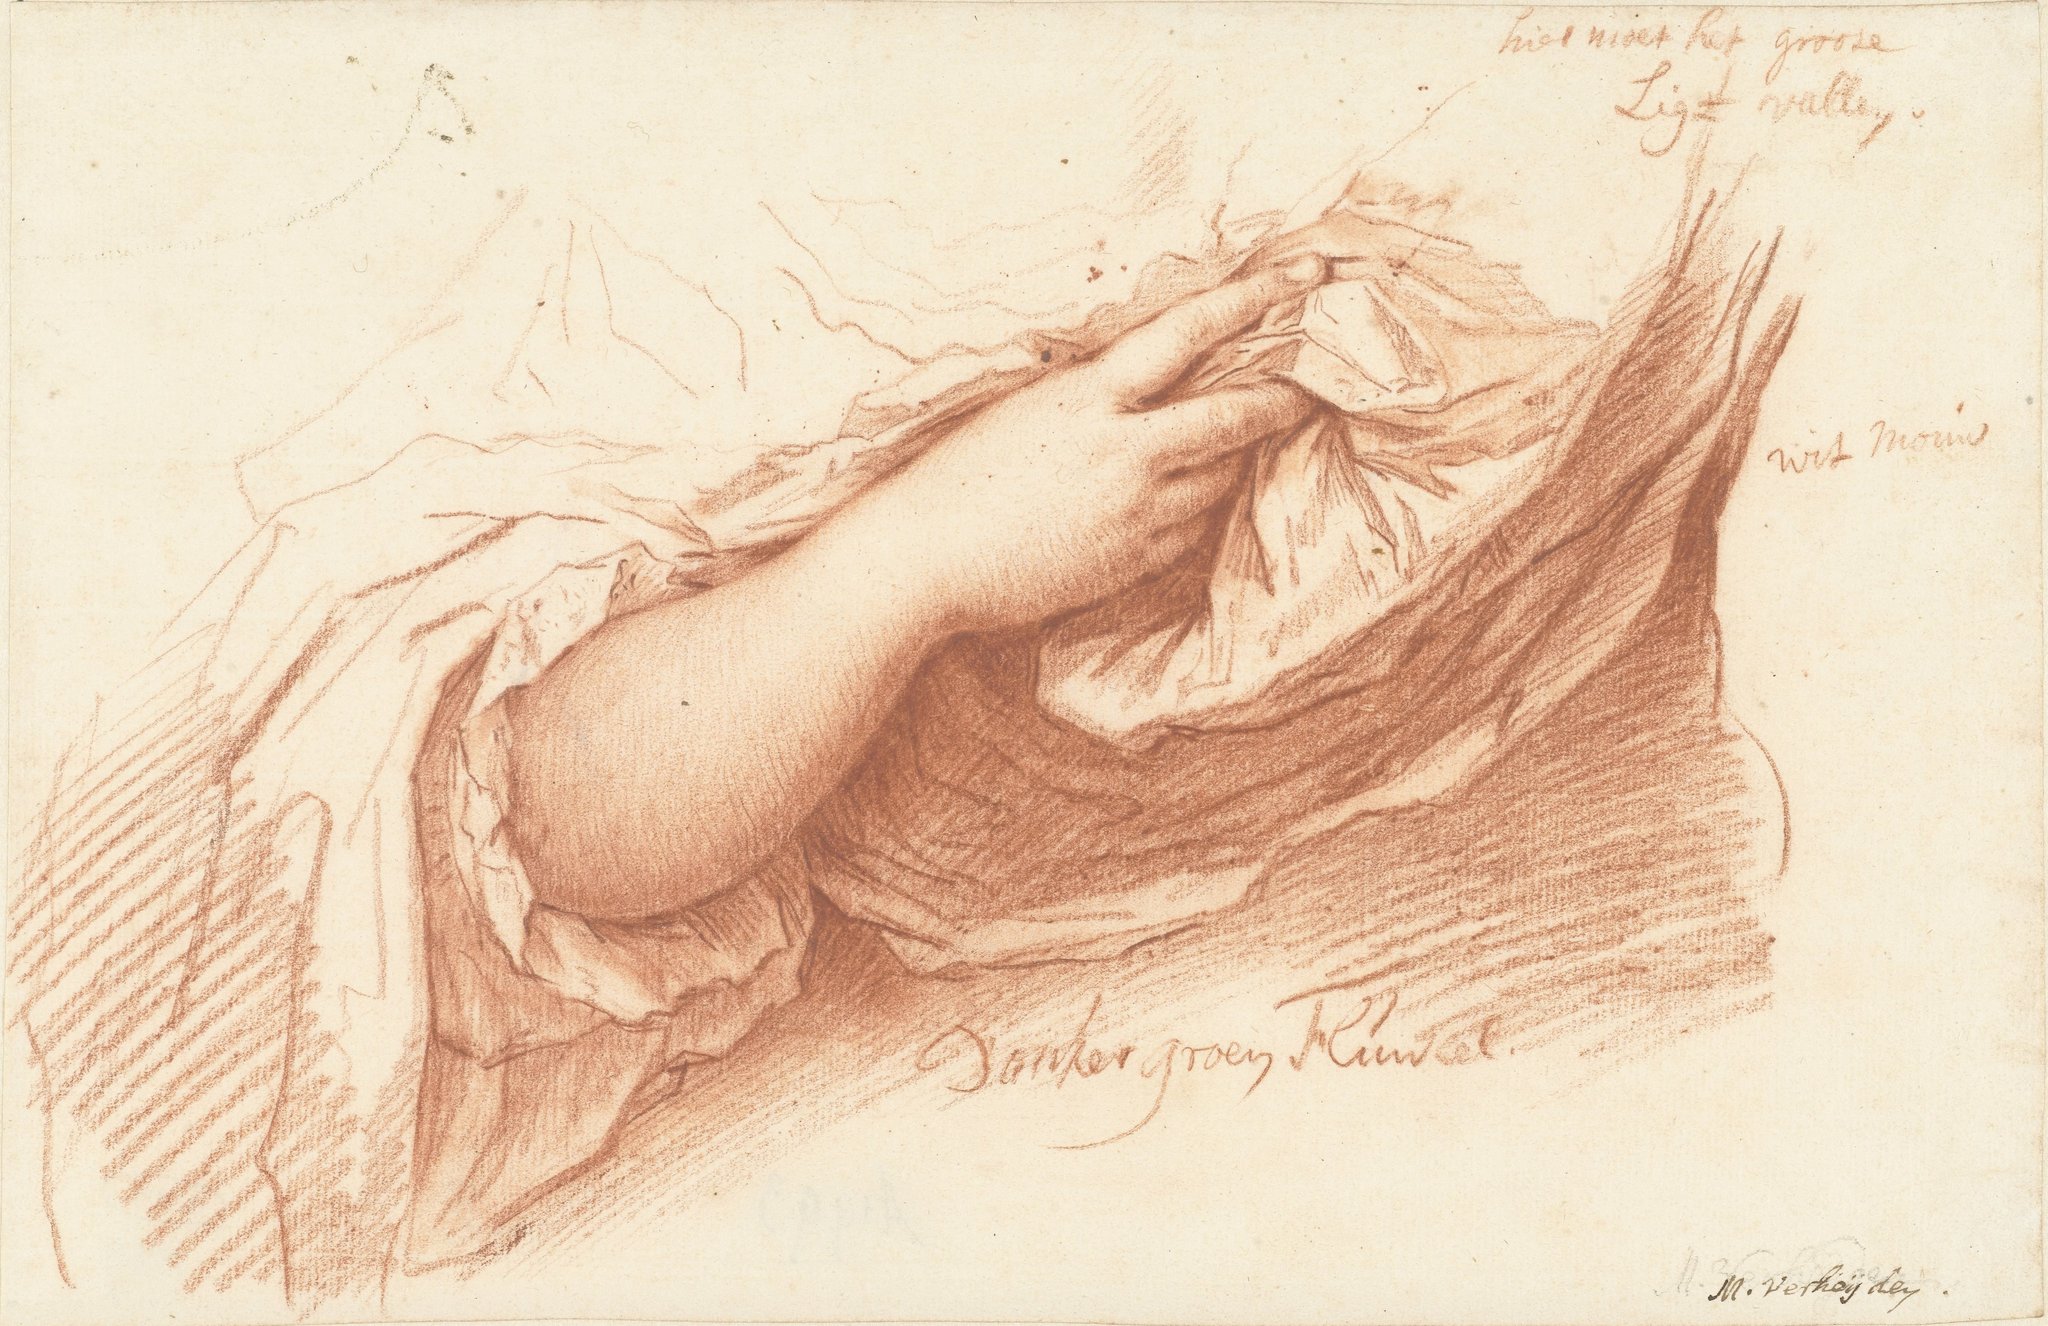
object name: drawing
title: Studie van een rechterarm en hand op een wijde mouw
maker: mattheus verheyden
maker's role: draughtsman, painter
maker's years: 1700-1777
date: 1710-1777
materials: chalk, paper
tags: lower arm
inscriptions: inscription: ‘Opschrift r.b.: `hier moet het groote Ligt vallen'; r.m.: `wit mouw'; m.o.: `Donkergroen Fluweel'. Sign. r.o.: M Verheijden.’